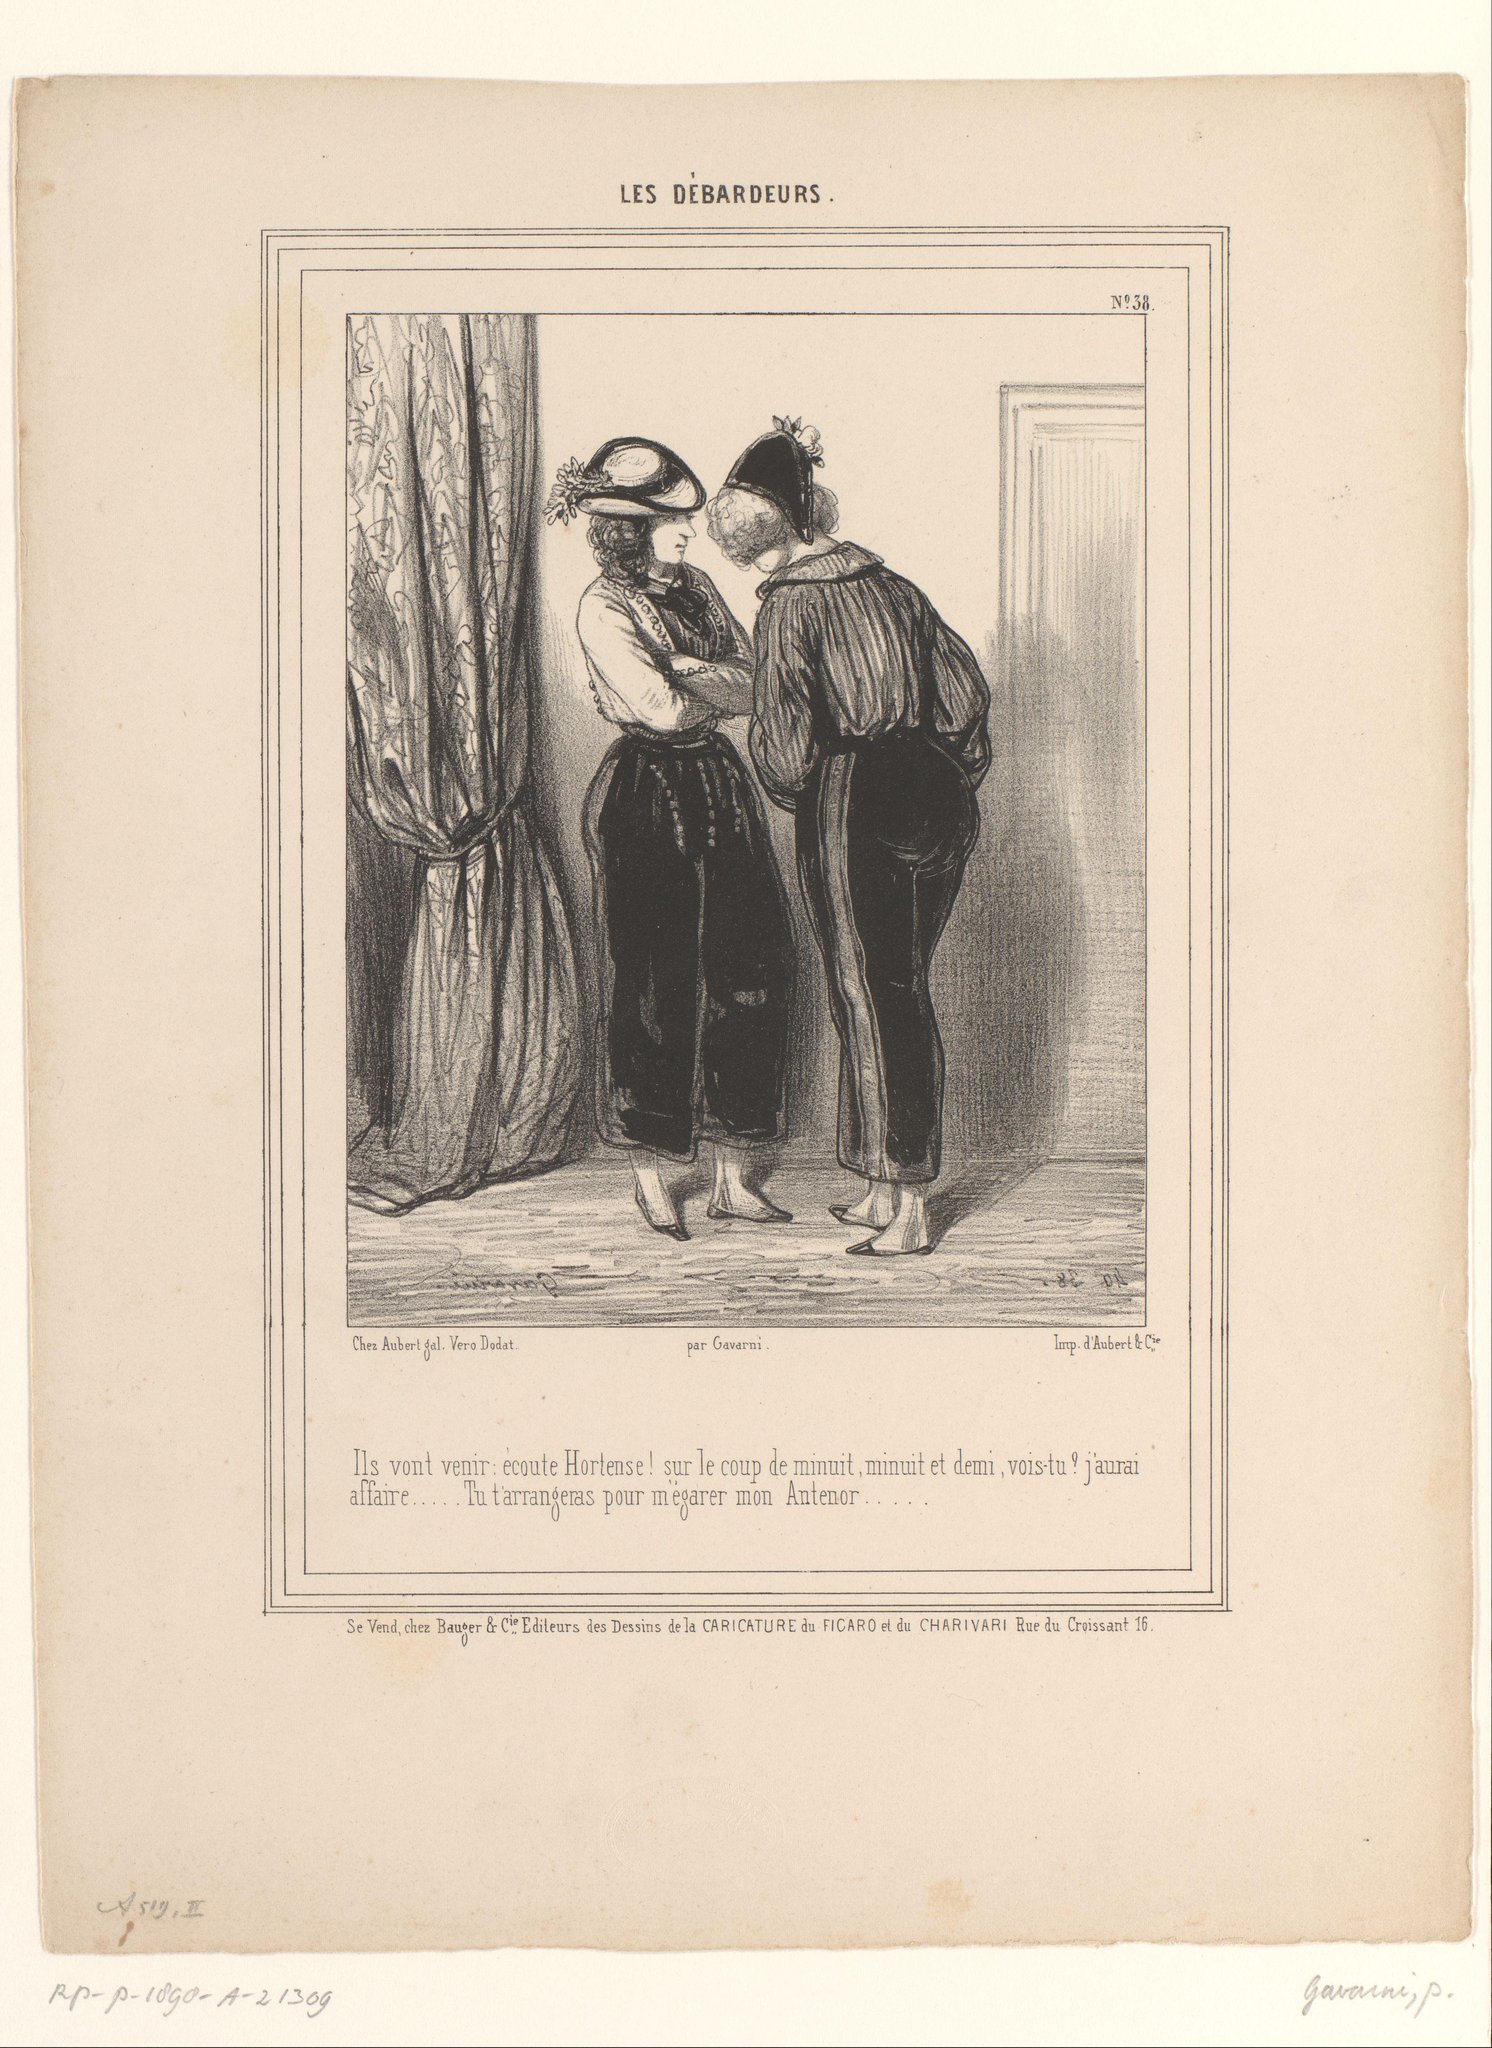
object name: print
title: Les débardeurs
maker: paul gavarni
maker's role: draughtsman, print maker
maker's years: 1804-1866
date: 1841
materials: paper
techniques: lithograph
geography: paris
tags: waiting, watching, fashion, clothing, standing figure - aa - female human figure, fashionable woman, 'belle'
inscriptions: collector's mark: Lugt 964, check stamp: Lugt 3855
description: Prent gebruikt voor: Le Charivari, 30 januari 1841.